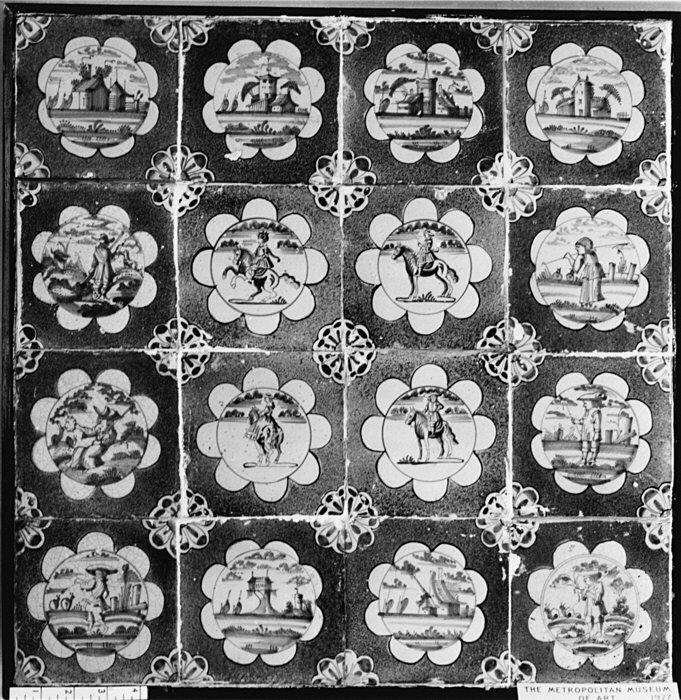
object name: tile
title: Tiles (16)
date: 1701-1800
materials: earthenware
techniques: glazing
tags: human figures,horses,landscapes